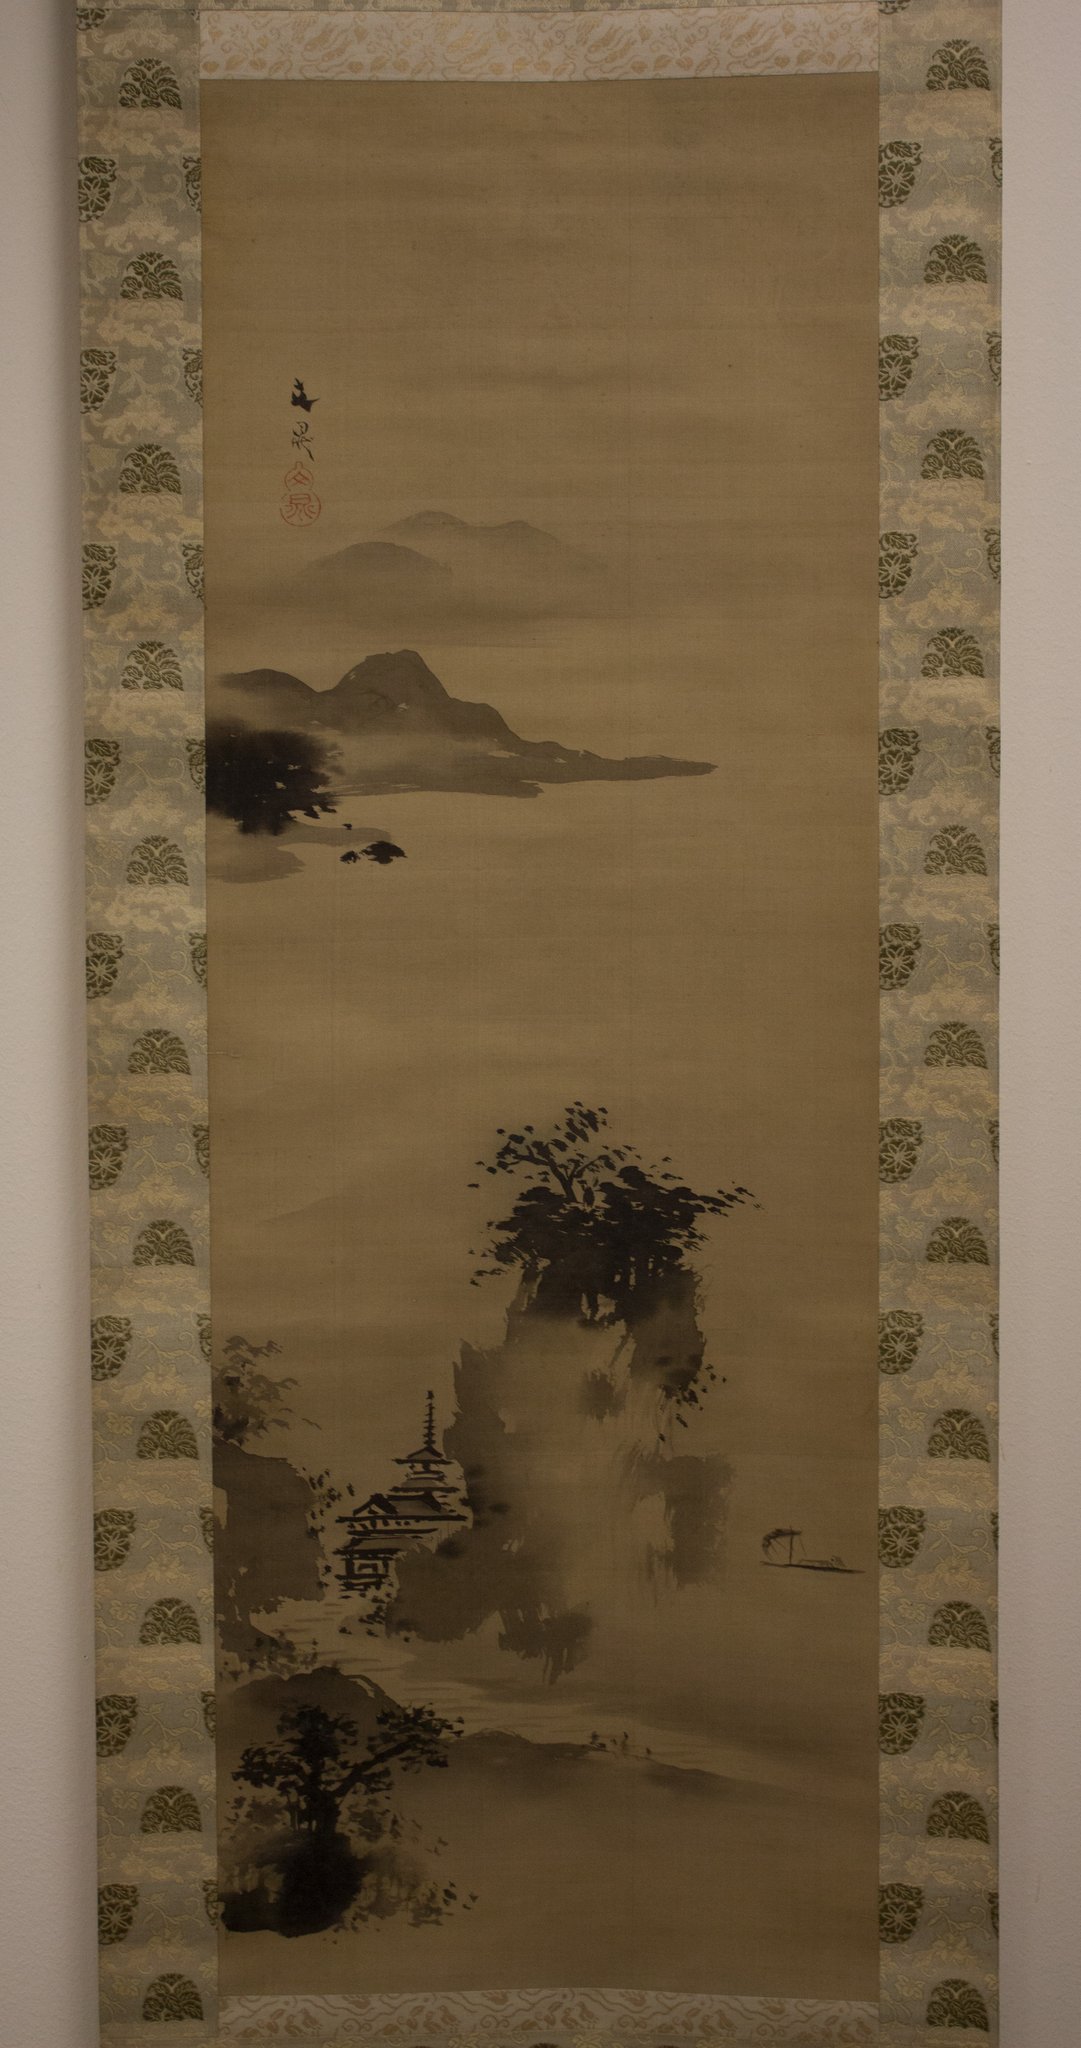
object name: hanging scroll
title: River Gorge with Waterfall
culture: japanese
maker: tani bunchō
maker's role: artist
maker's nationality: japanese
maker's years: 1763-1840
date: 1763-1840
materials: ink, silk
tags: landscapes